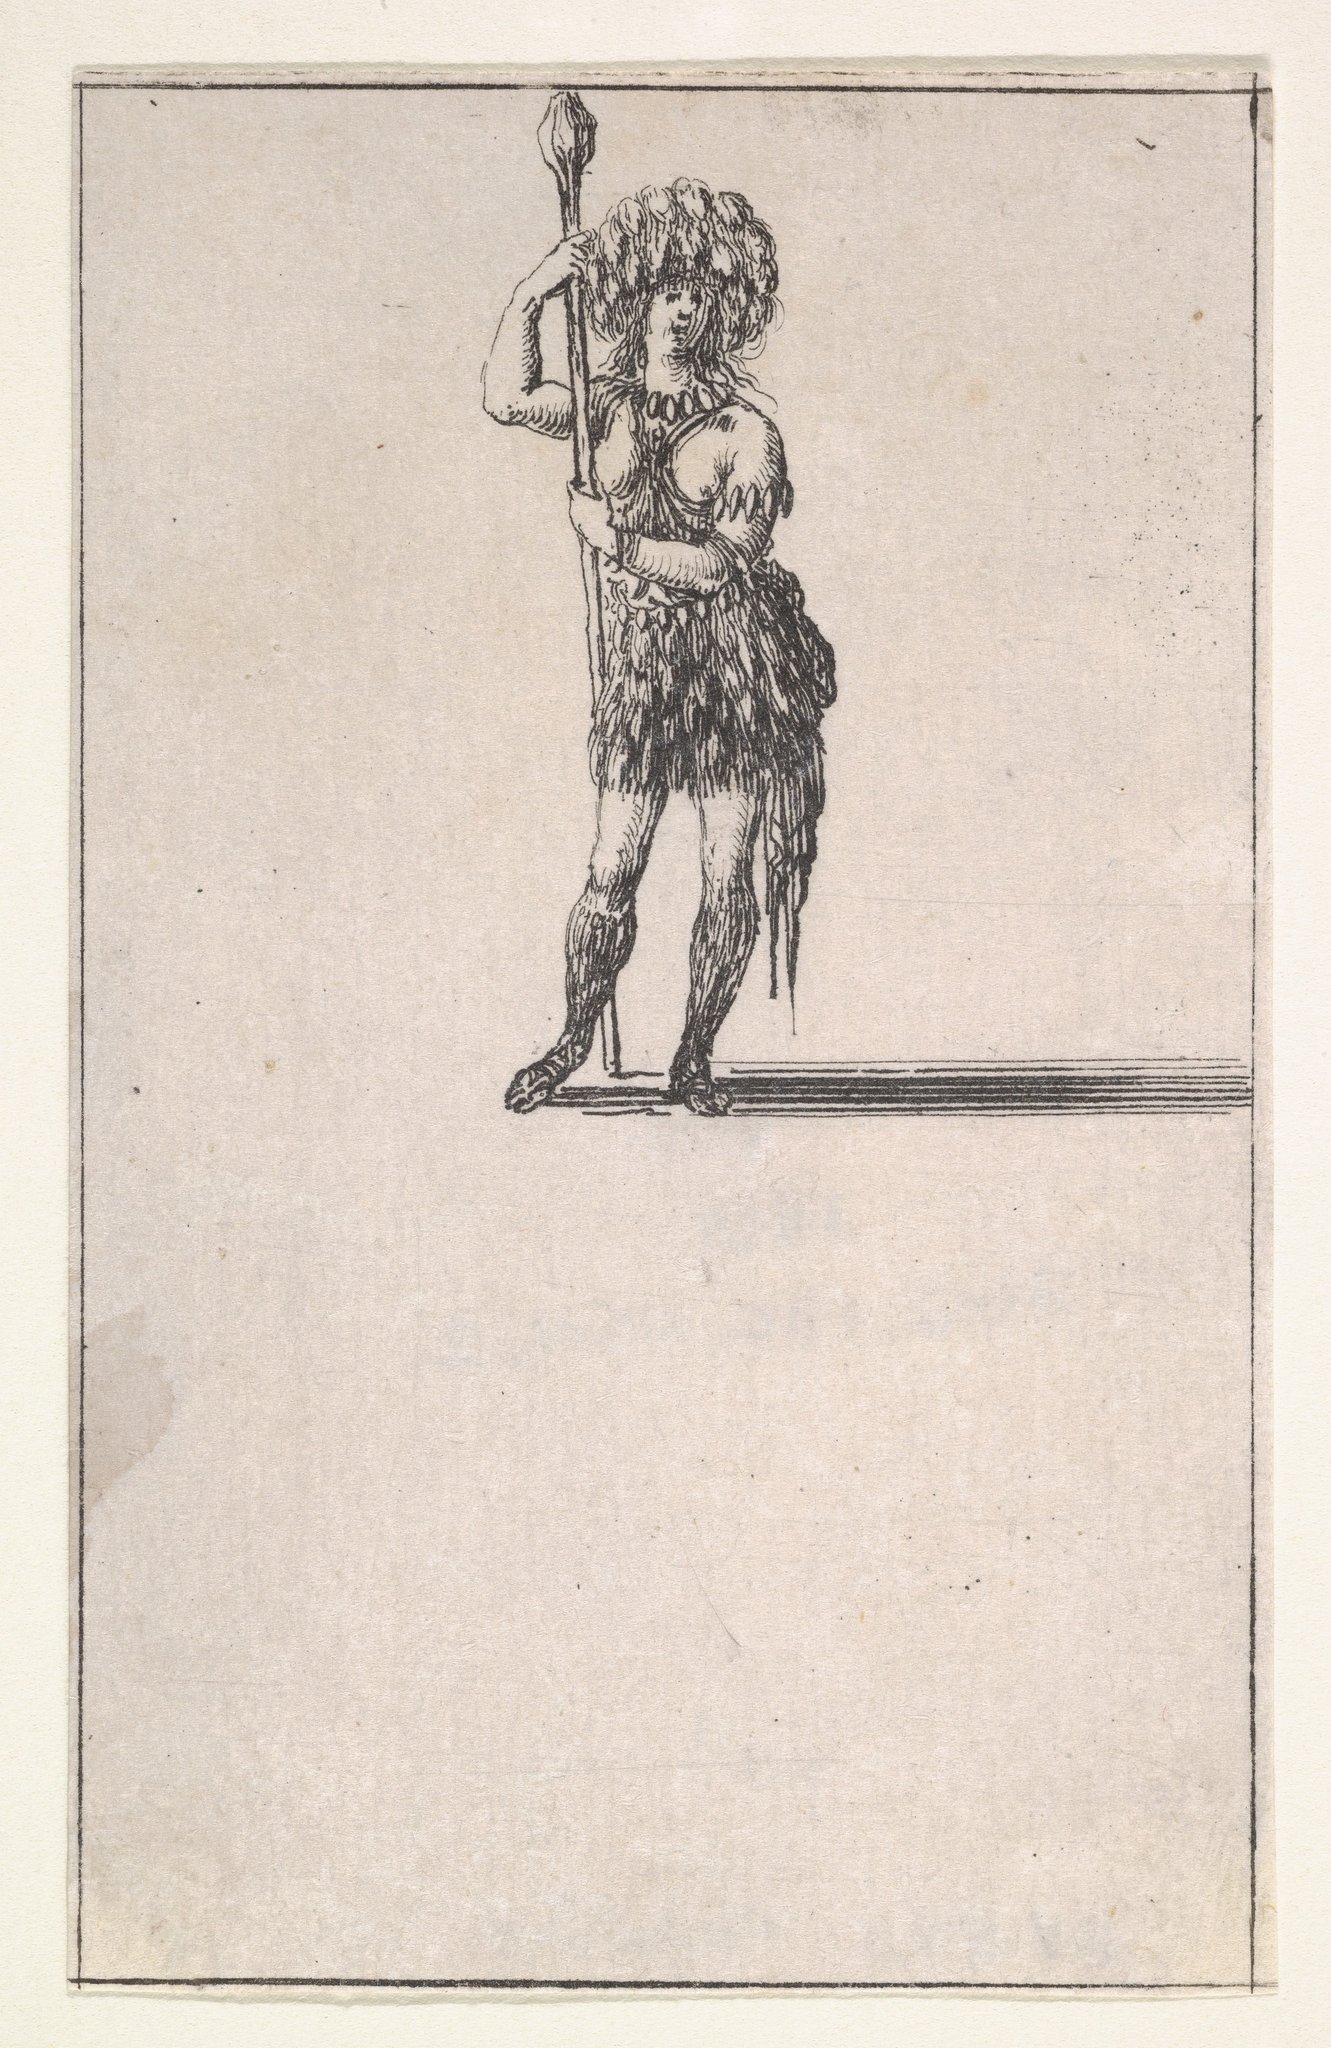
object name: print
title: Popaian, from "Game of Geography" (Jeu de la Géographie)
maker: stefano della bella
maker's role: artist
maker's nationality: italian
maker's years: 1610-1664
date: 1644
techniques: etching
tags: women